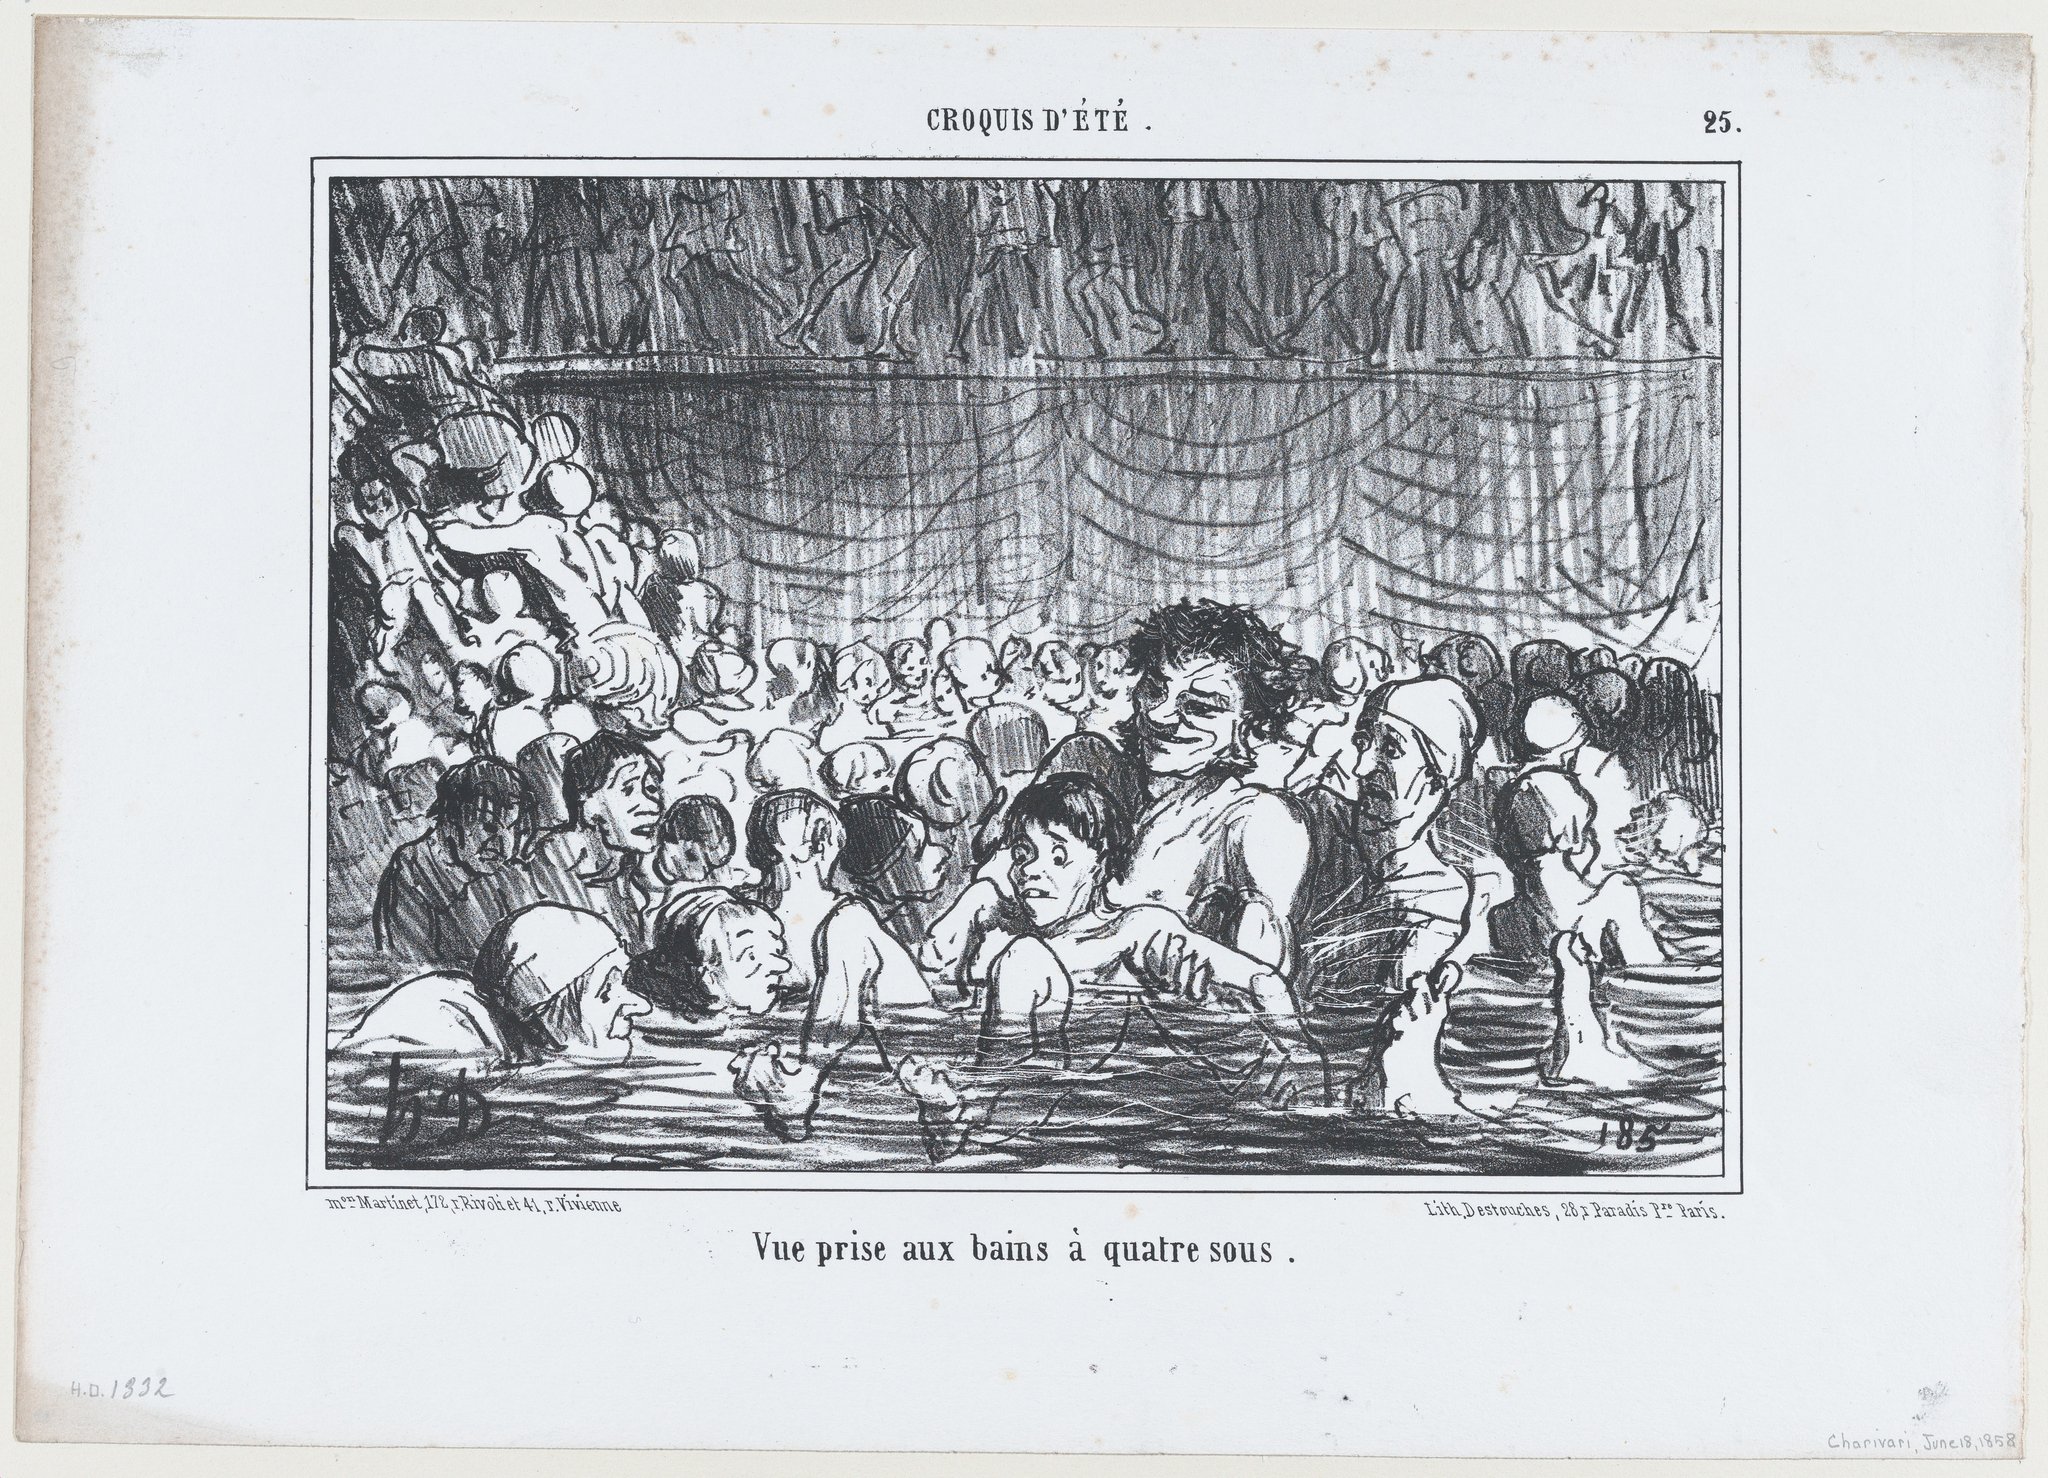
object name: print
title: Vue prise aux bains à quatre sous, from Croquis d'Été, published in Le Charivari, June 18, 1858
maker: honoré daumier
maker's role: artist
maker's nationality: french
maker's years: 1808-1879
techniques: lithograph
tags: men,bathing